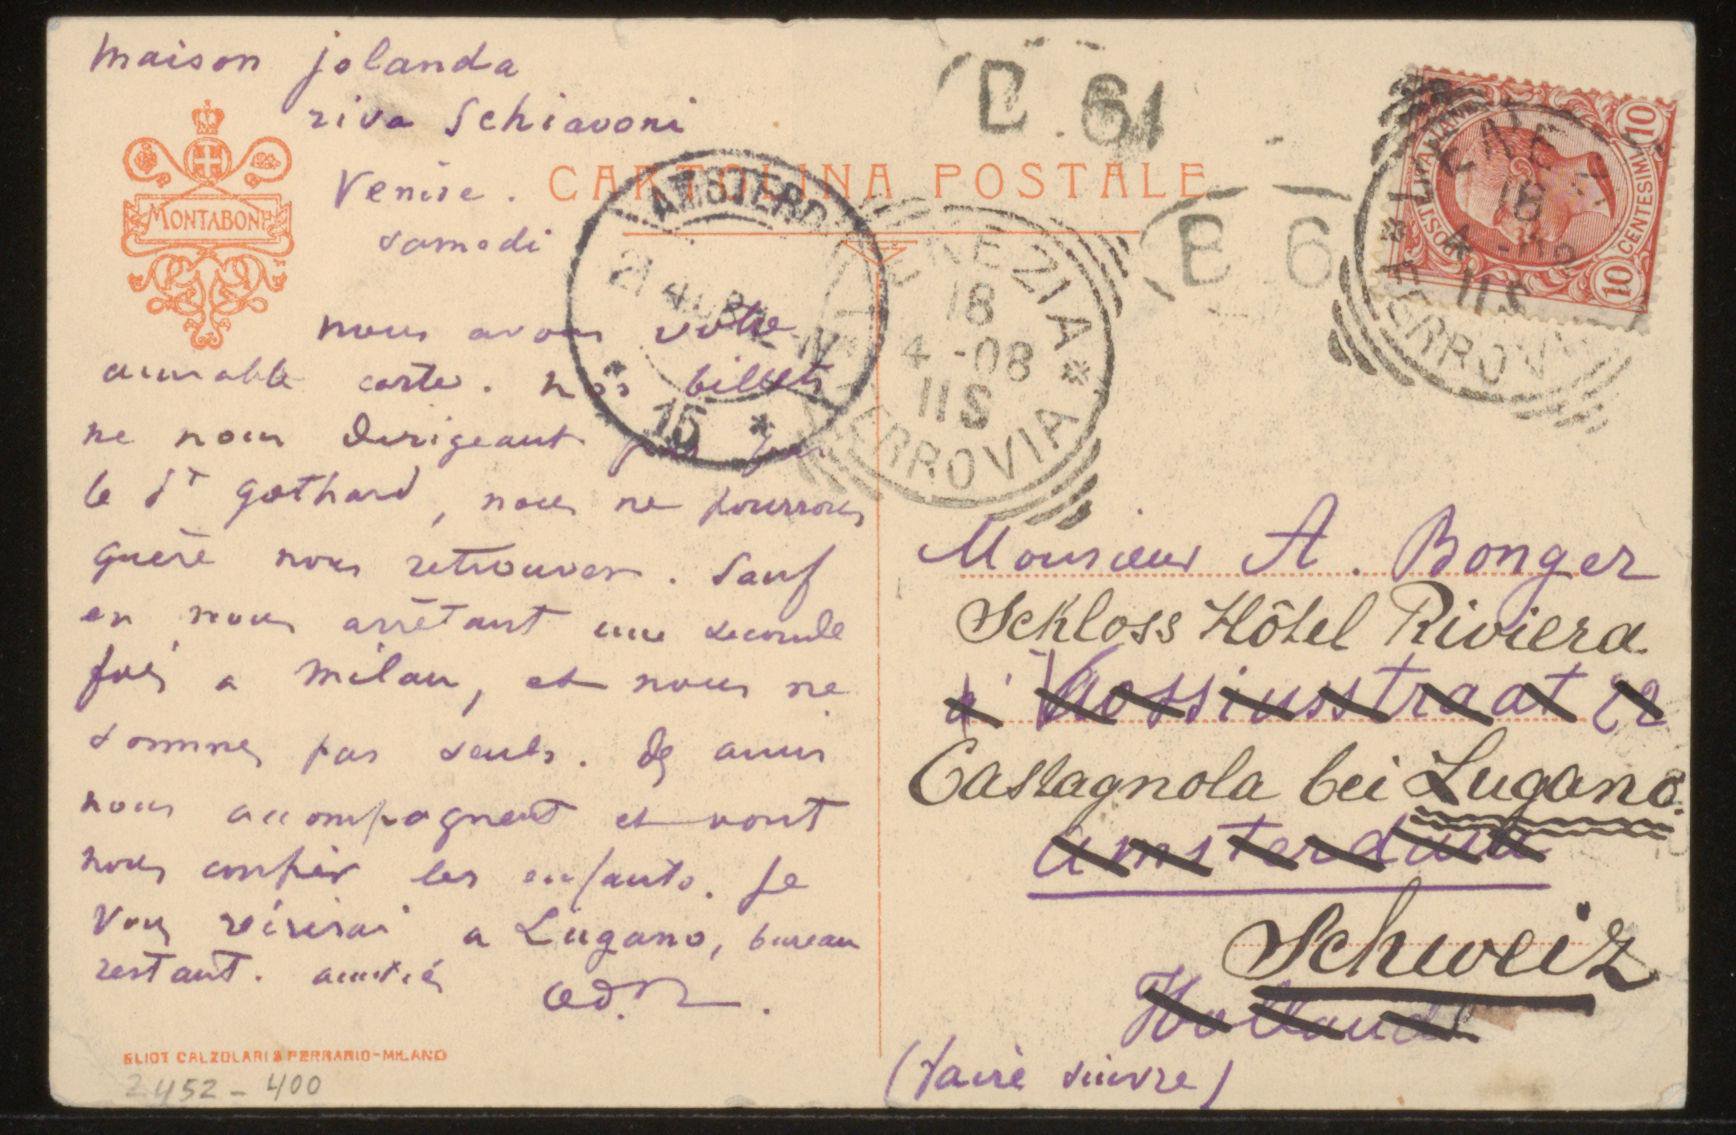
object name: ansichtkaart, prentbriefkaart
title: Prentbriefkaart aan Andries Bonger en Anne Marie Louise van der Linden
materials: cardboard, ink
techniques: photograph, pen, writing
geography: venice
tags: amsterdam, andries bonger, travelling; tourism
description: Prentbriefkaart behoort tot een album samengesteld door weduwe Françoise W.M. Barones van der Borch van Verwolde met afschriften van brieven met betrekking tot (de familie van) Odilon Redon. De prentbriefkaart werd bewaard op pagina 144.